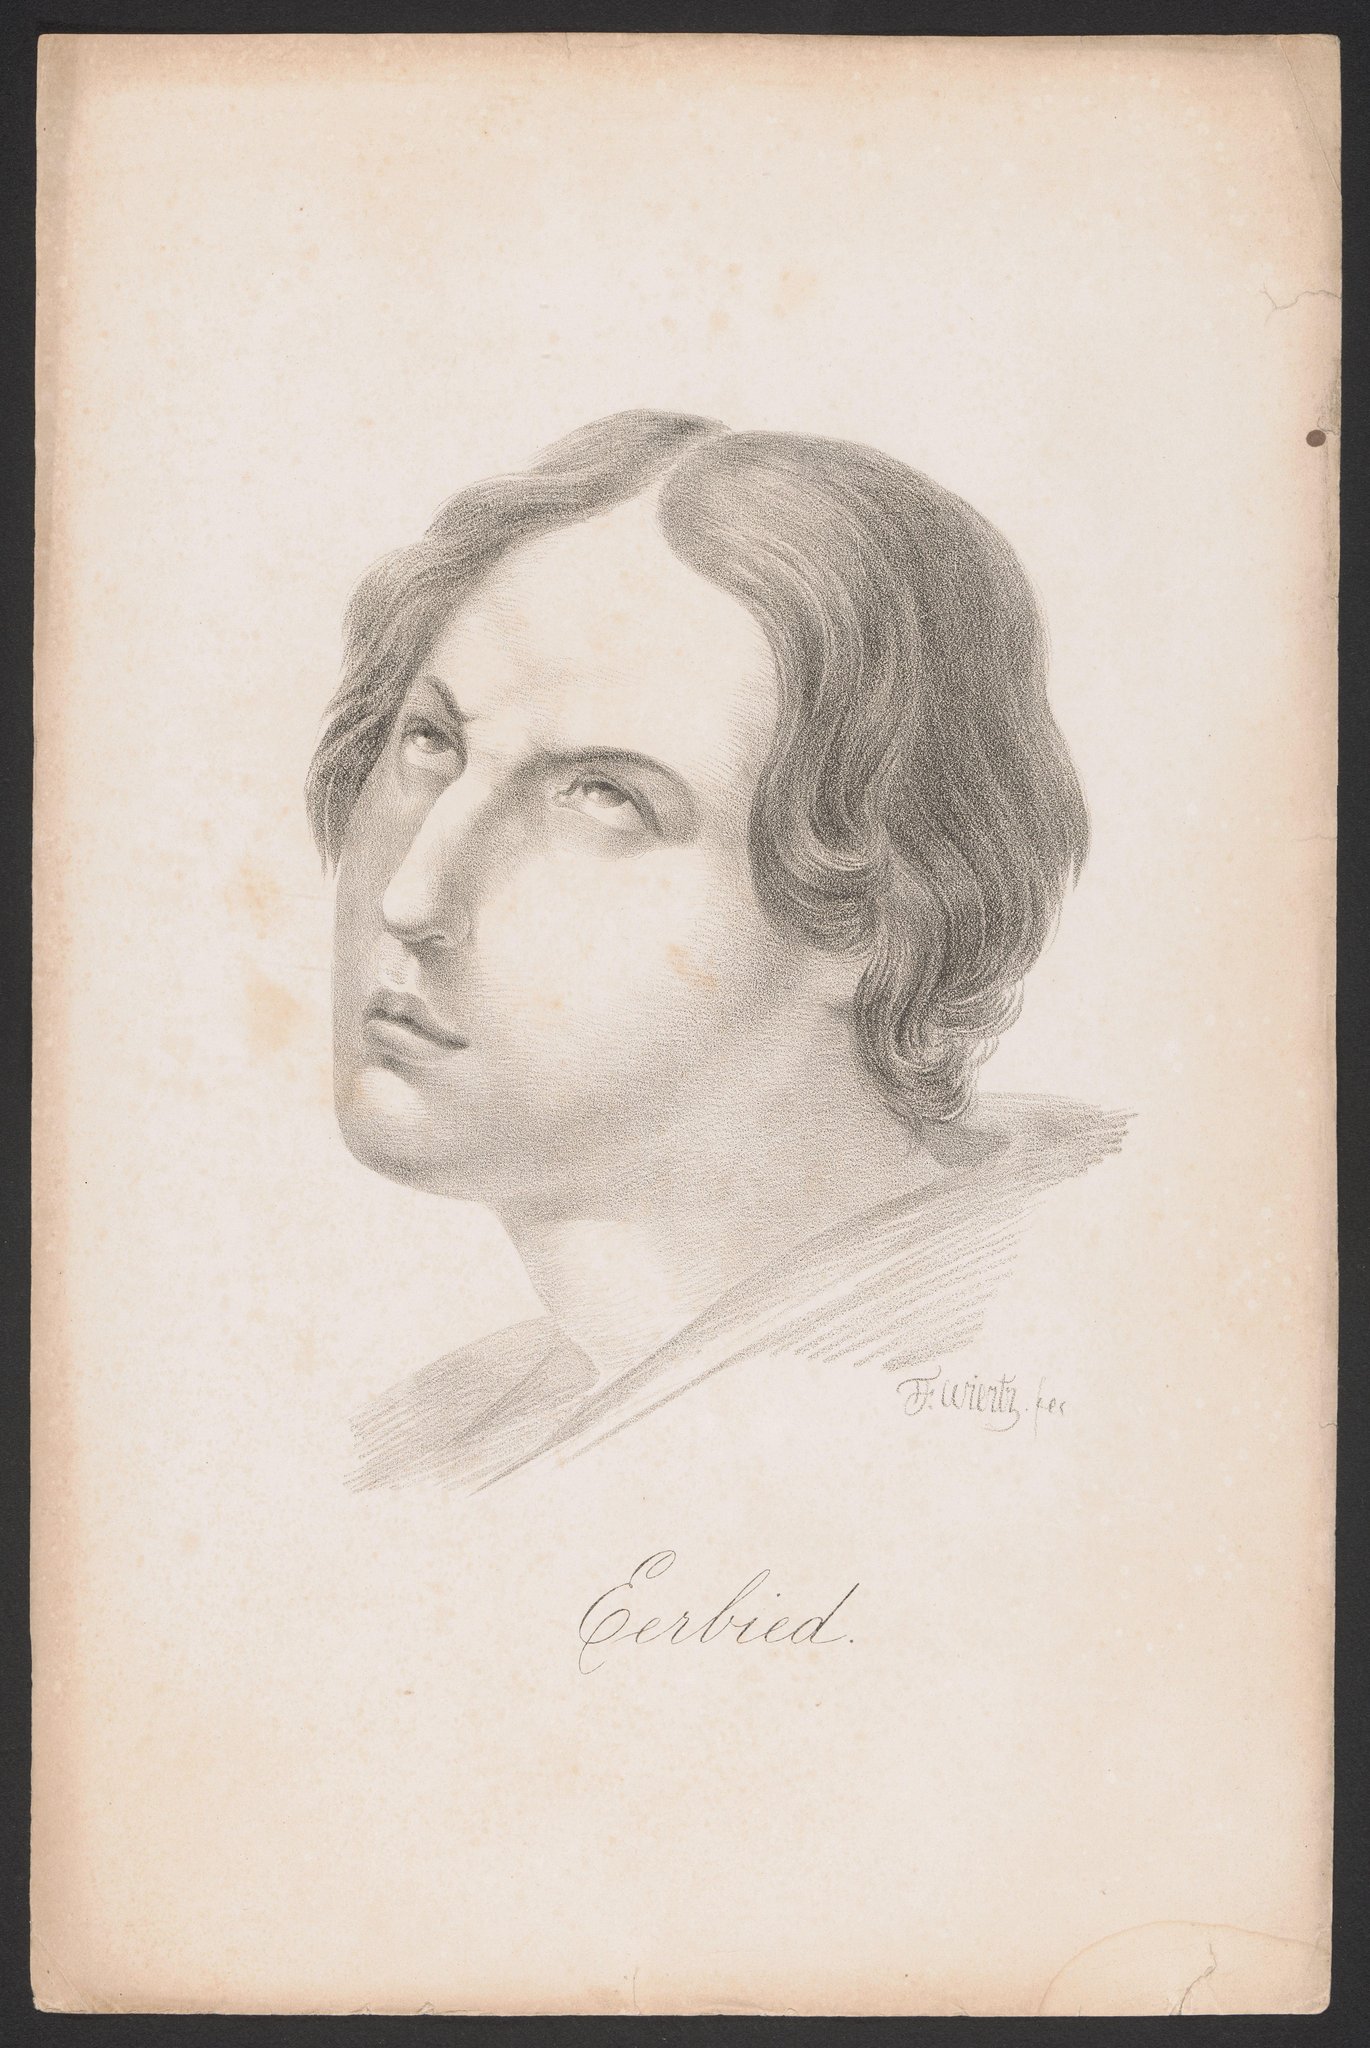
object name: print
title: Twaalf voorstellingen van hartstogten, tevens geschikt voor studiën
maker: henricus franciscus wiertz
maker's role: draughtsman, painter, print maker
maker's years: 1784-1858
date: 1847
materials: paper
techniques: lithograph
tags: historical persons (+ head (and shoulders) (portrait)), passions, emotions, affections, respect, reverence, esteem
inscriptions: collector's mark: Lugt 2228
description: Maakt deel uit van een omslag met een tekstblad en twaalf prenten.